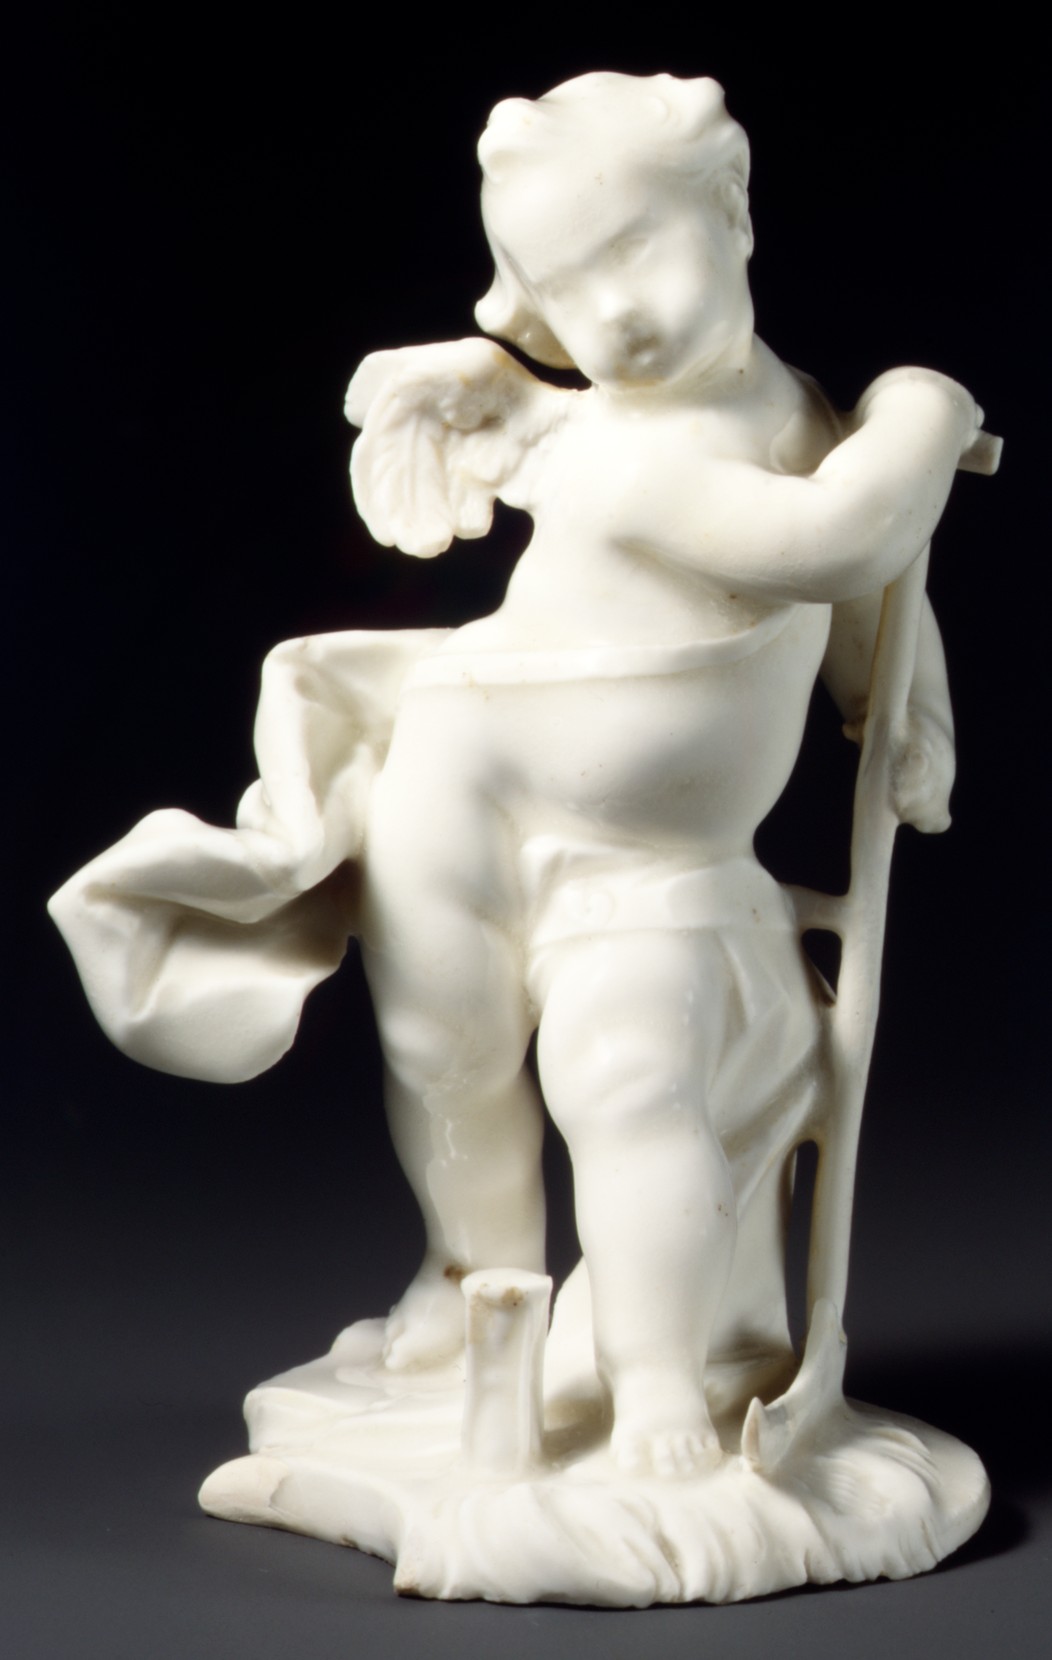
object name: figure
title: Putto as Saturn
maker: nymphenburg porcelain manufactory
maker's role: manufactory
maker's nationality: german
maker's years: 1747-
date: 1755-1756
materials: hard paste porcelain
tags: putti,saturn